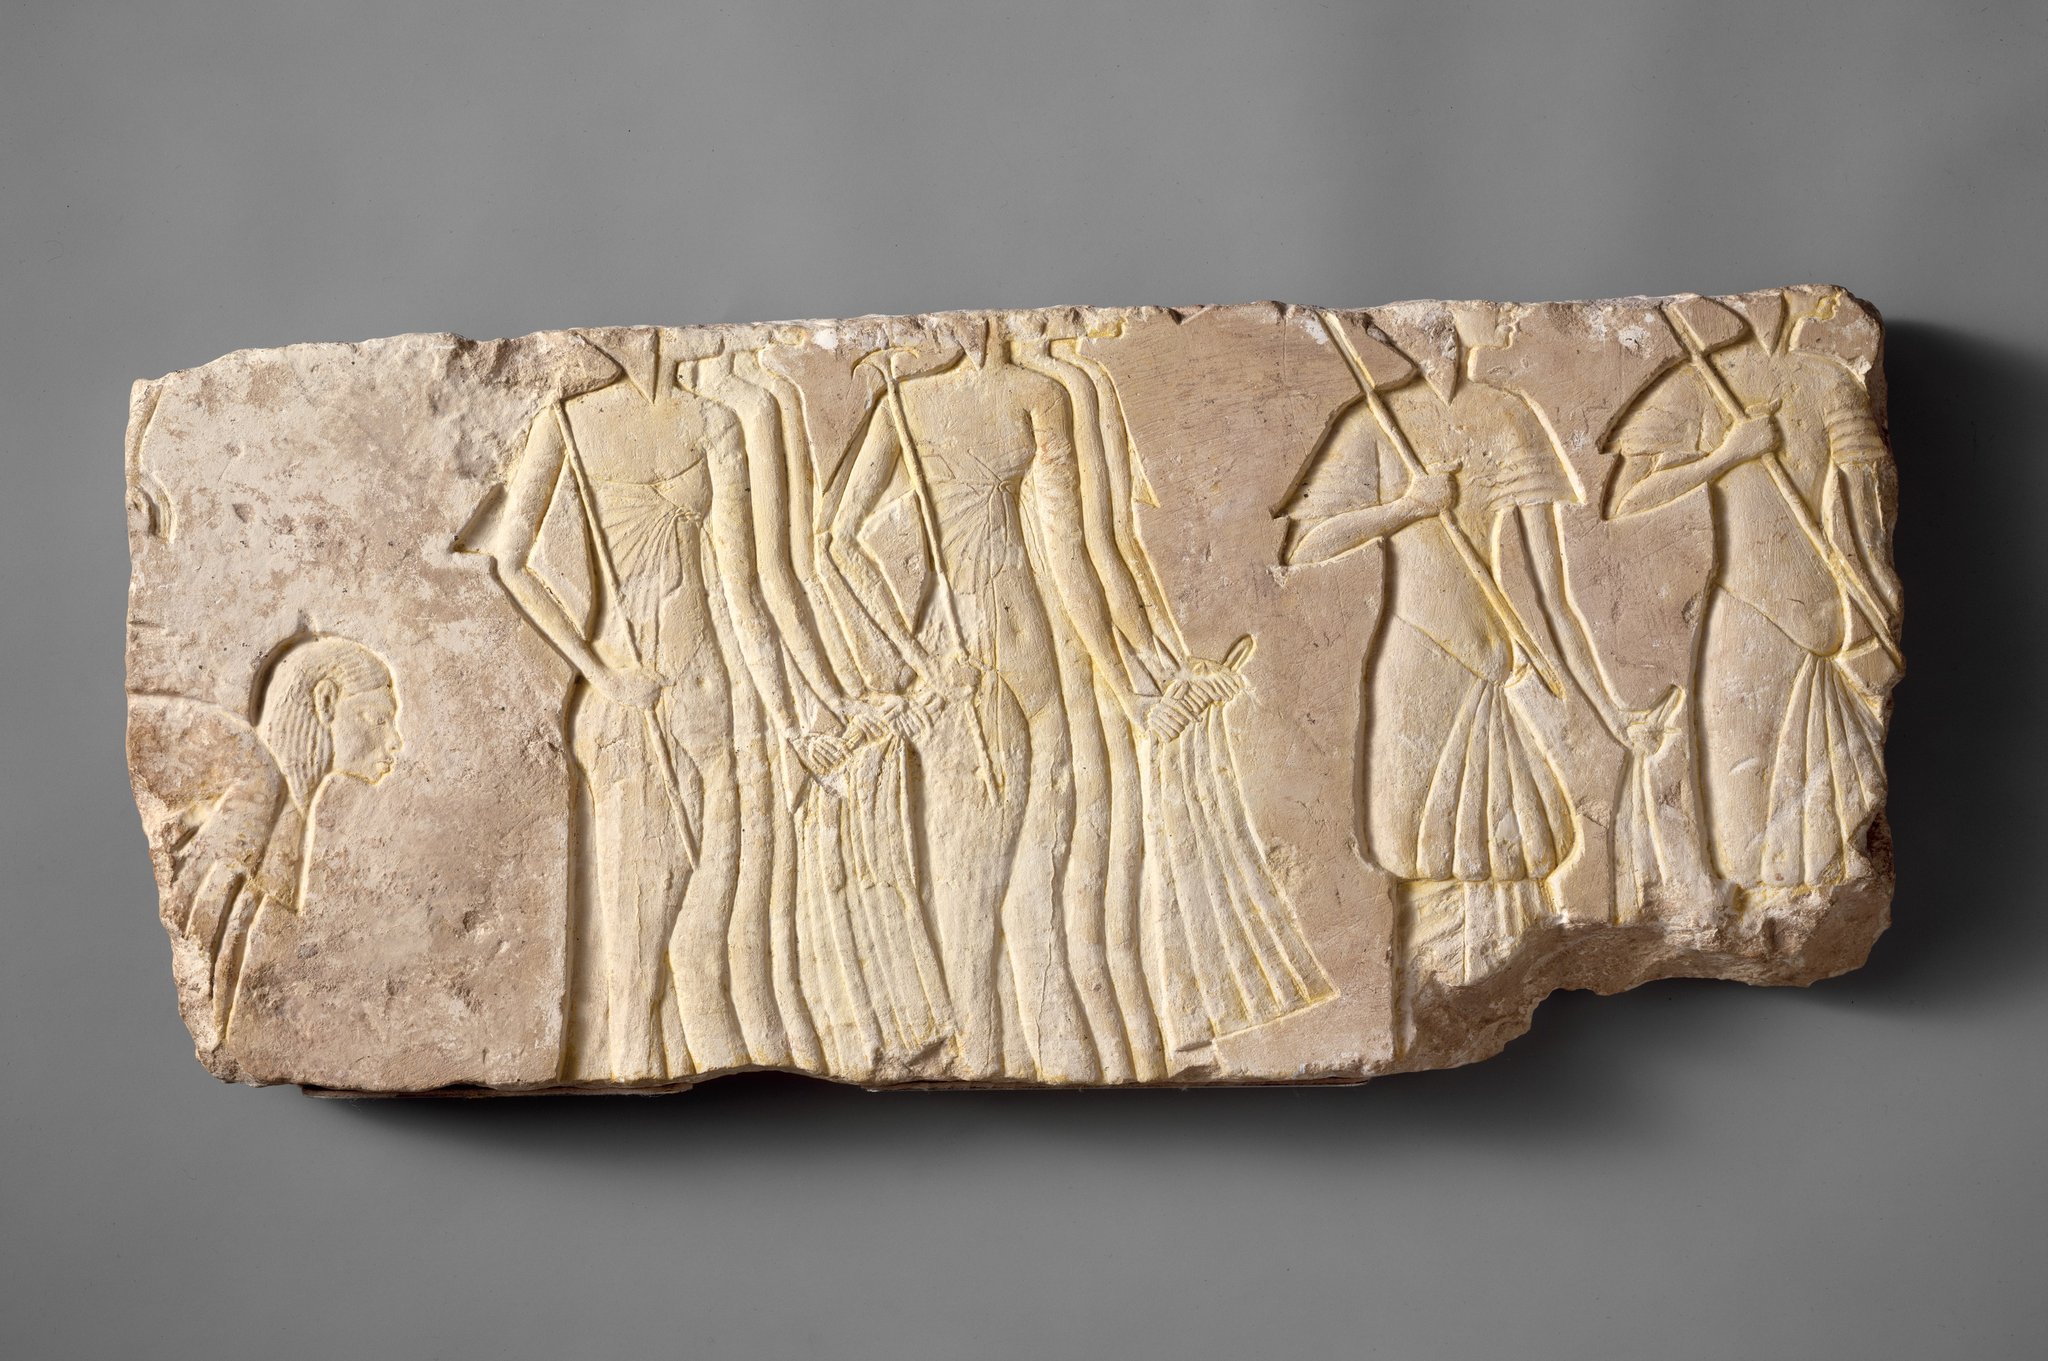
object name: talatat, attendant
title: Male and Female Attendants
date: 1353-1336 BCE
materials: limestone, paint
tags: men,women